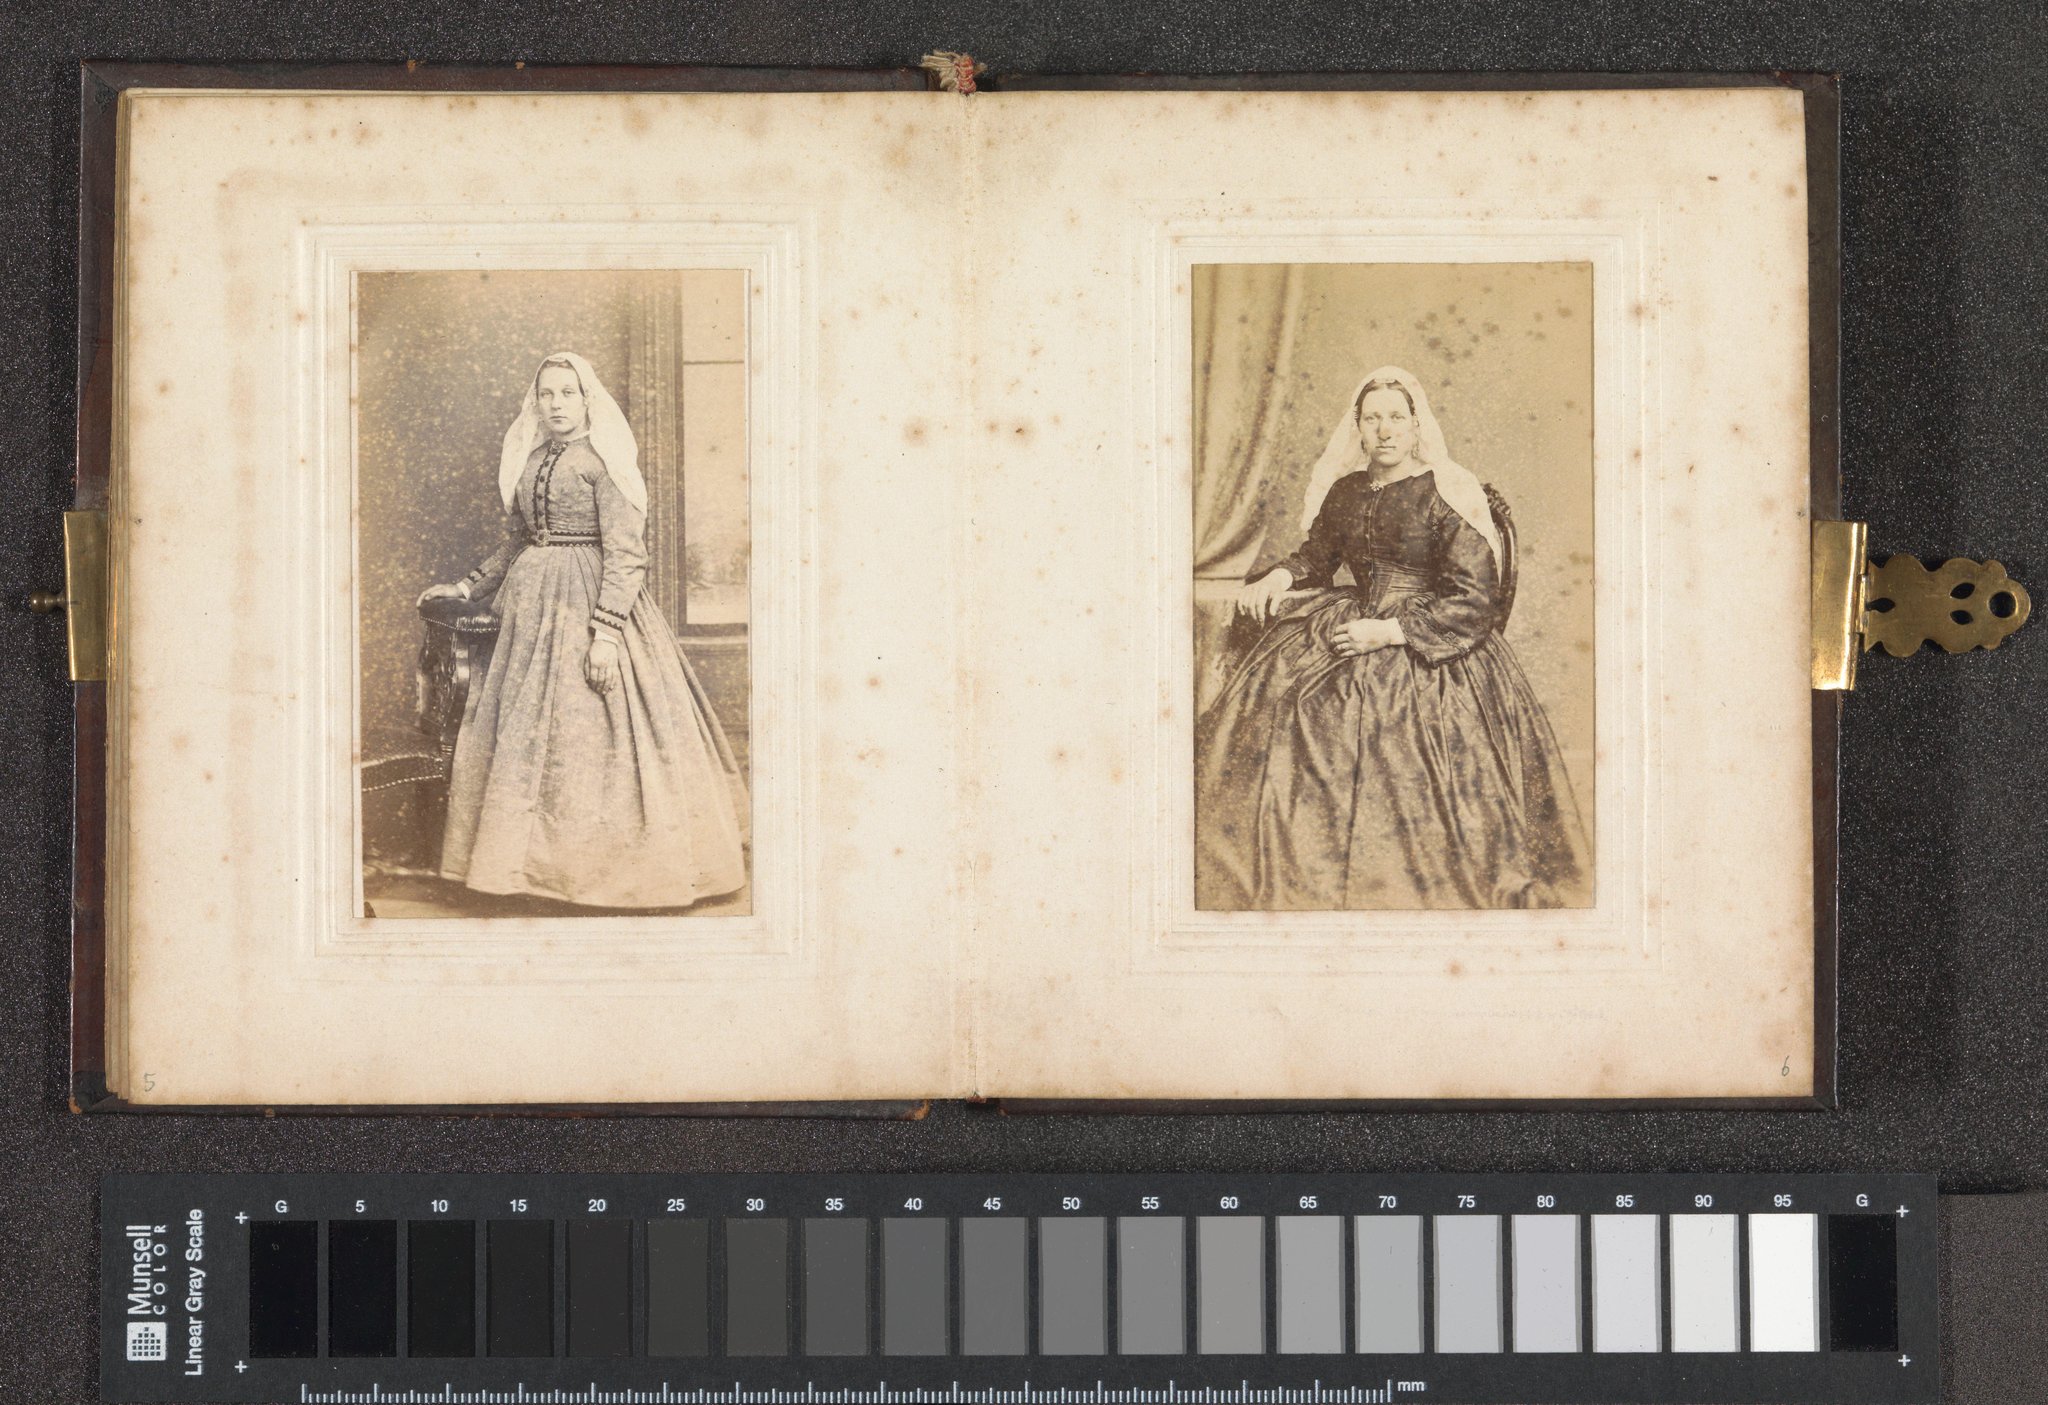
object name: carte de visite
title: Portret van een vrouw met een sluiermuts, staand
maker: c. j. korsten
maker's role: painter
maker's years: 1829-1914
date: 1860-1875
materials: cardboard, paper, photographic support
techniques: albumen print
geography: zierikzee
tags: folk costume, regional costume (+ women's clothes), adult woman, studio requisites ~ photographer, historical persons, family life, head-gear: cap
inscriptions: address: ‘Zierikzee’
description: Onderdeel van Fotoalbum met cartes-de-visite van een Zeeuwse familie.